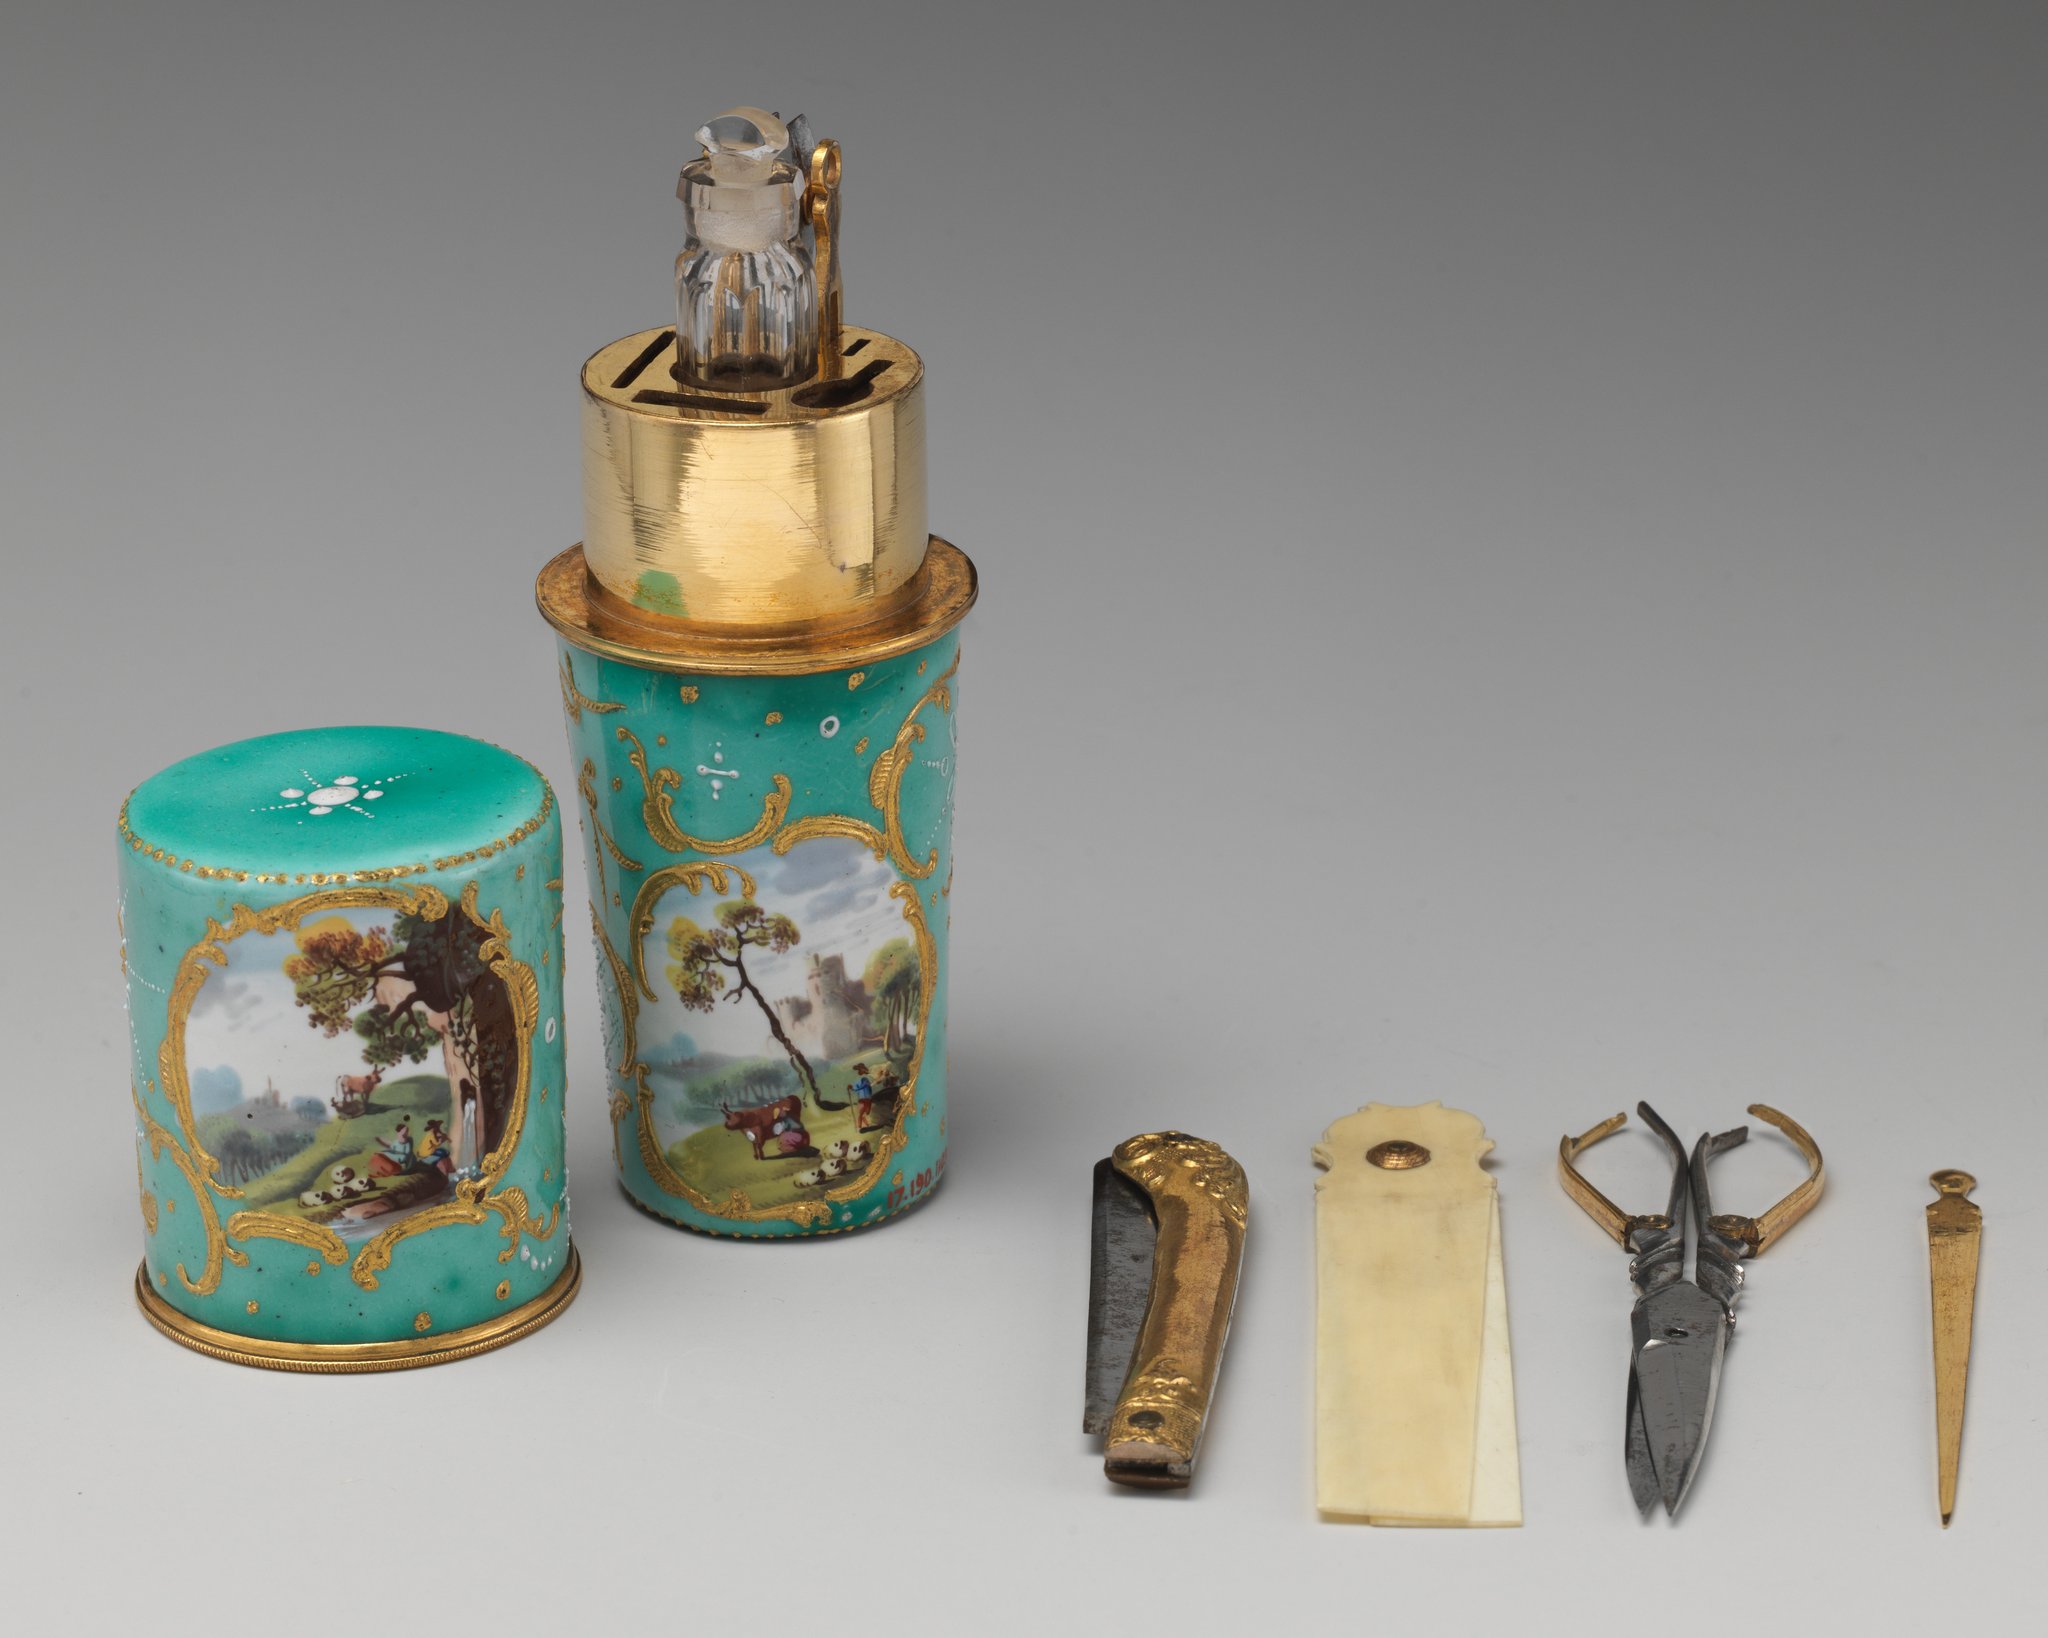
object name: étui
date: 1765-1770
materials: copper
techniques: enamel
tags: animals,men